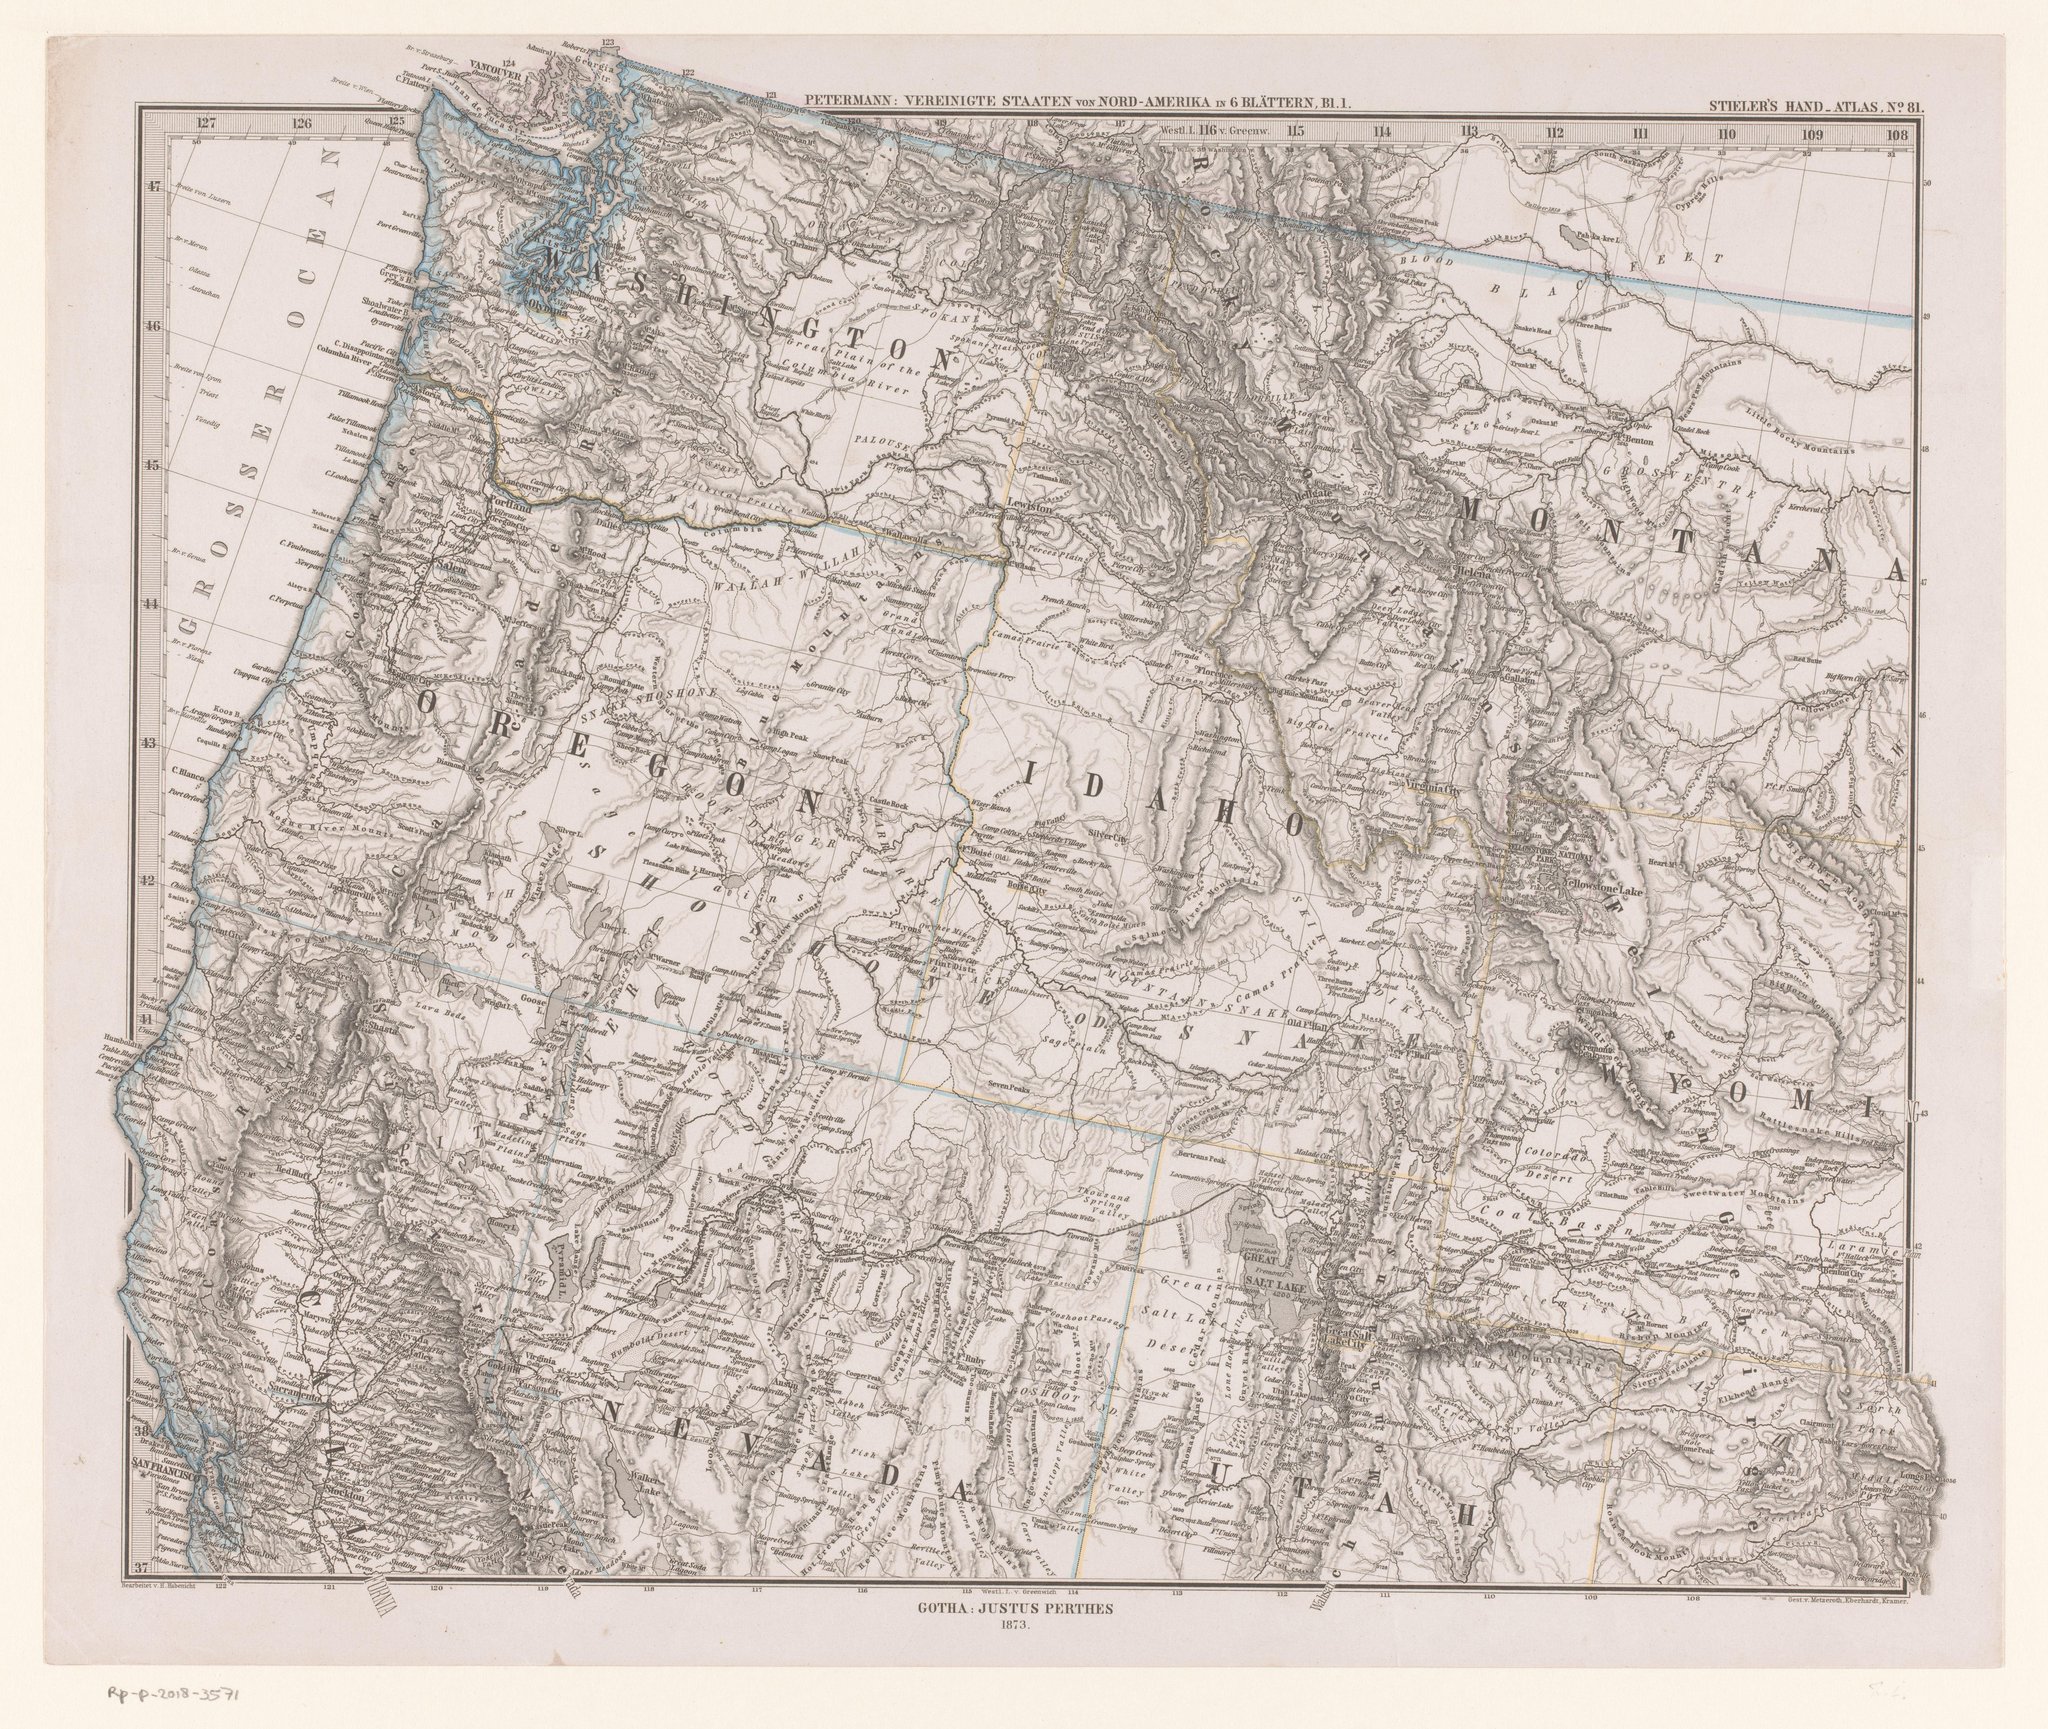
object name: map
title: Kaart van een gedeelte van de Verenigde Staten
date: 1873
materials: paper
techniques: hand coloring, lithograph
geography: gotha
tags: maps, atlases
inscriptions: date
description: Kaart van een gedeelte van de Verenigde Staten in Noord-Amerika. Onder andere: Washington, Montana, Idaho, Wyomi, Oregon, Utah, Nevada en Californië. Rechtsboven: "Stieler's Hand_Atlas N81".